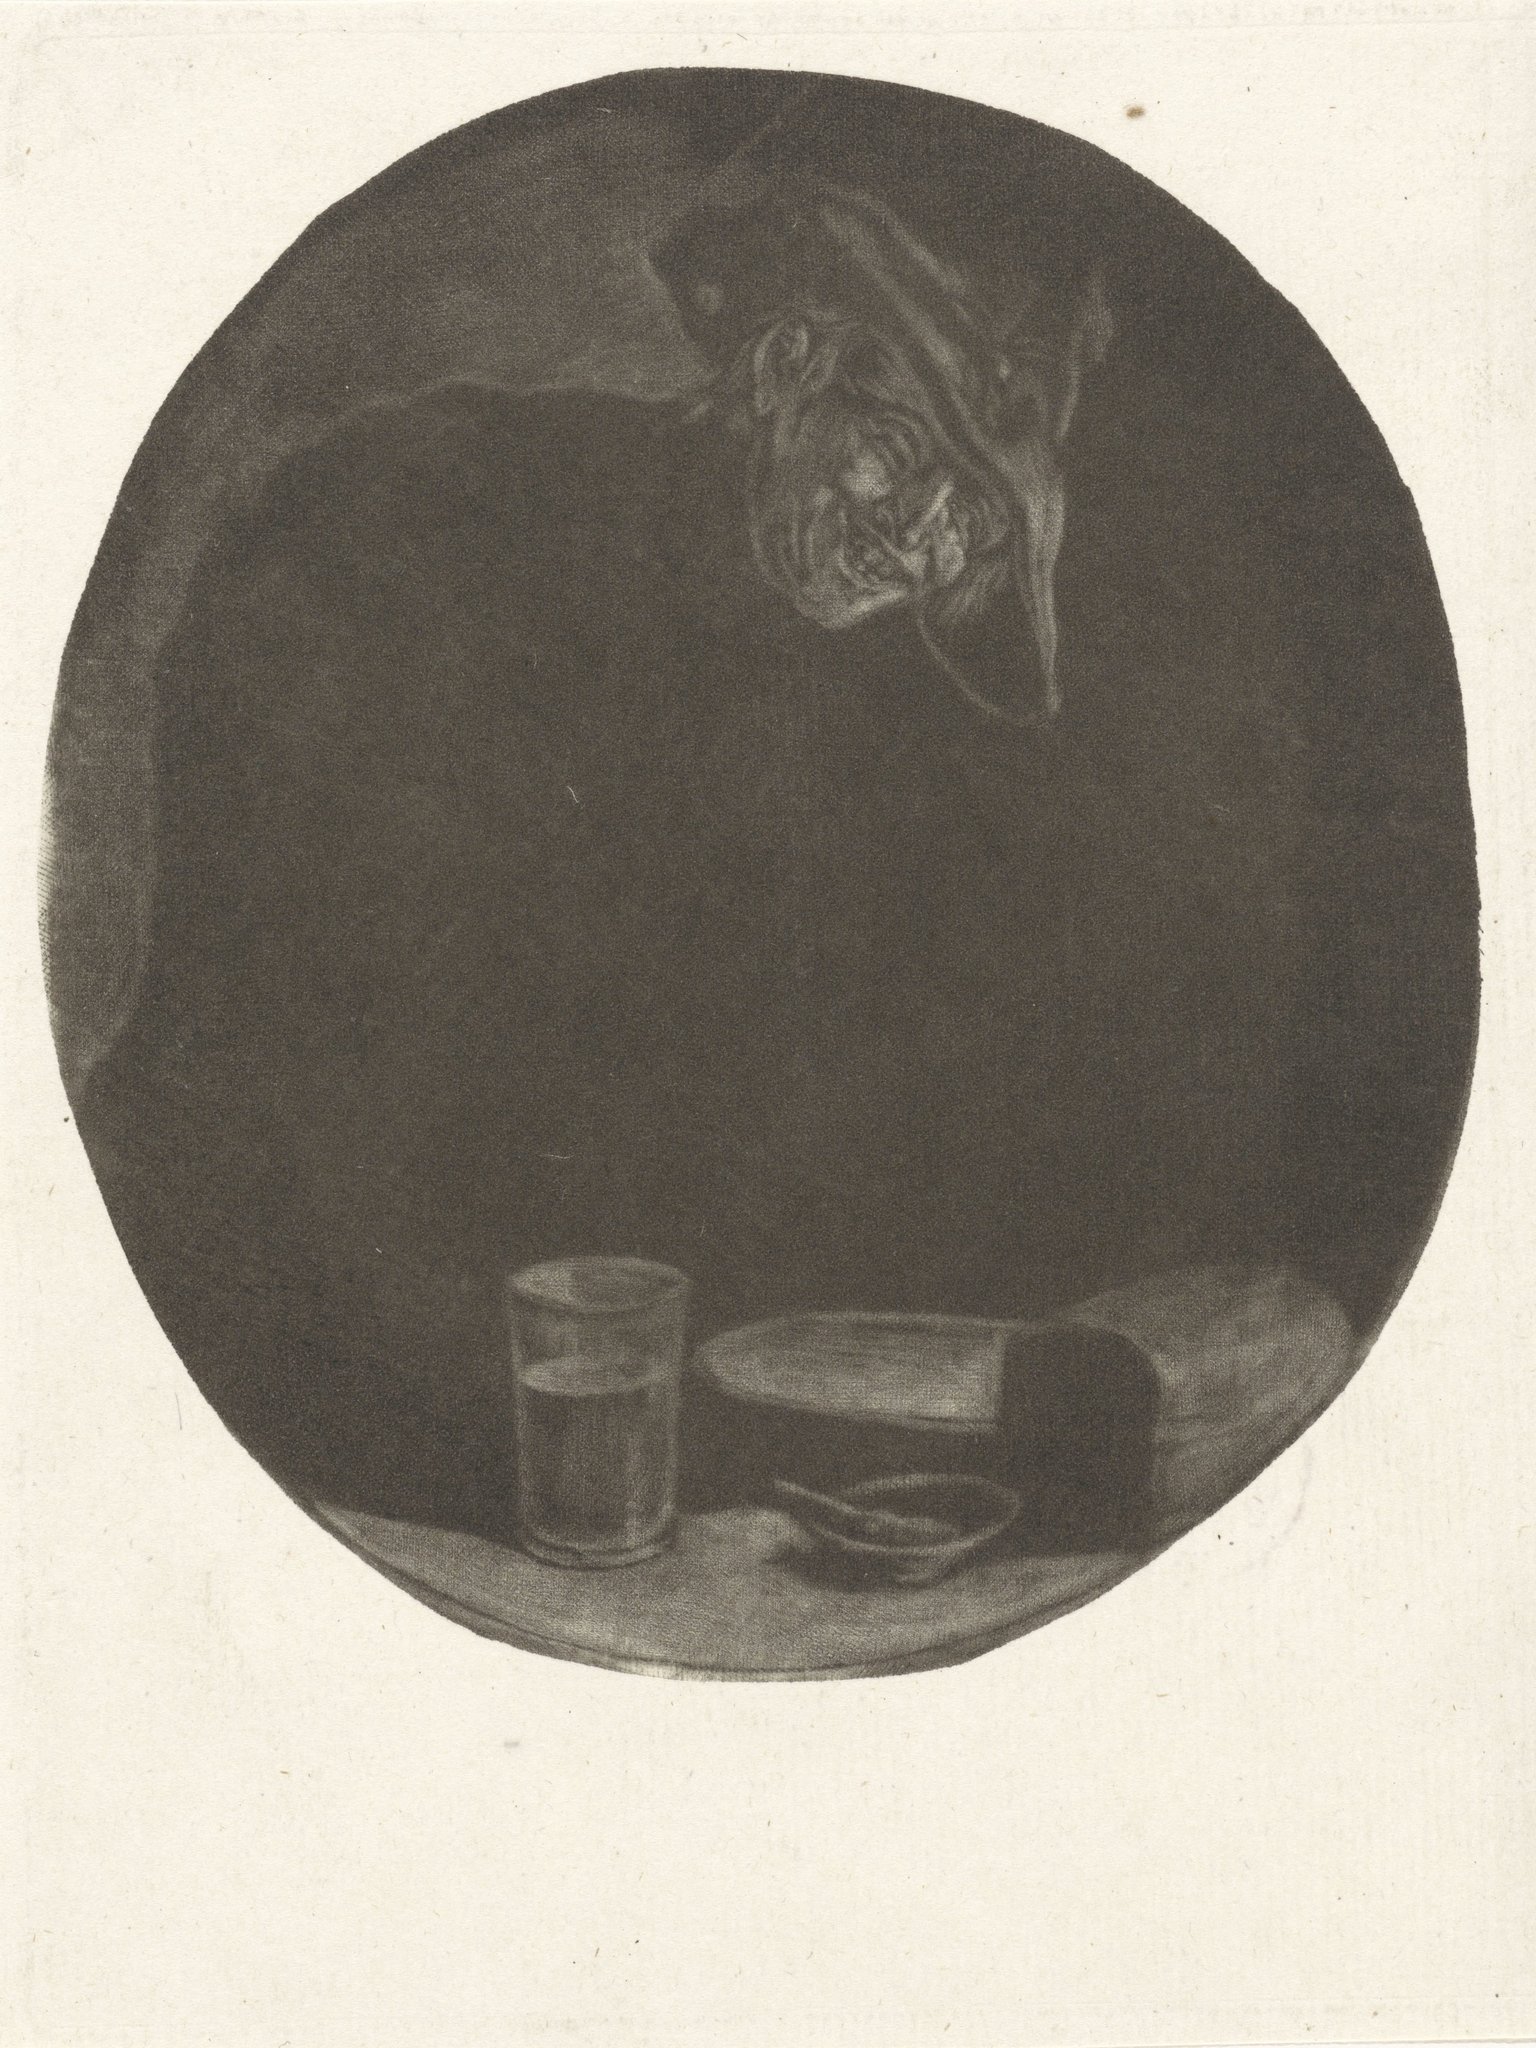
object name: print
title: Lachende boer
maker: jacob gole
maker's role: print maker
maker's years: 1660-1724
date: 1670-1724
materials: paper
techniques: mezzotint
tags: farmers, laughing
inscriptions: collector's mark: Lugt 240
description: Een lachende boer bij een tafel waarop een glas, schotel en een kom.